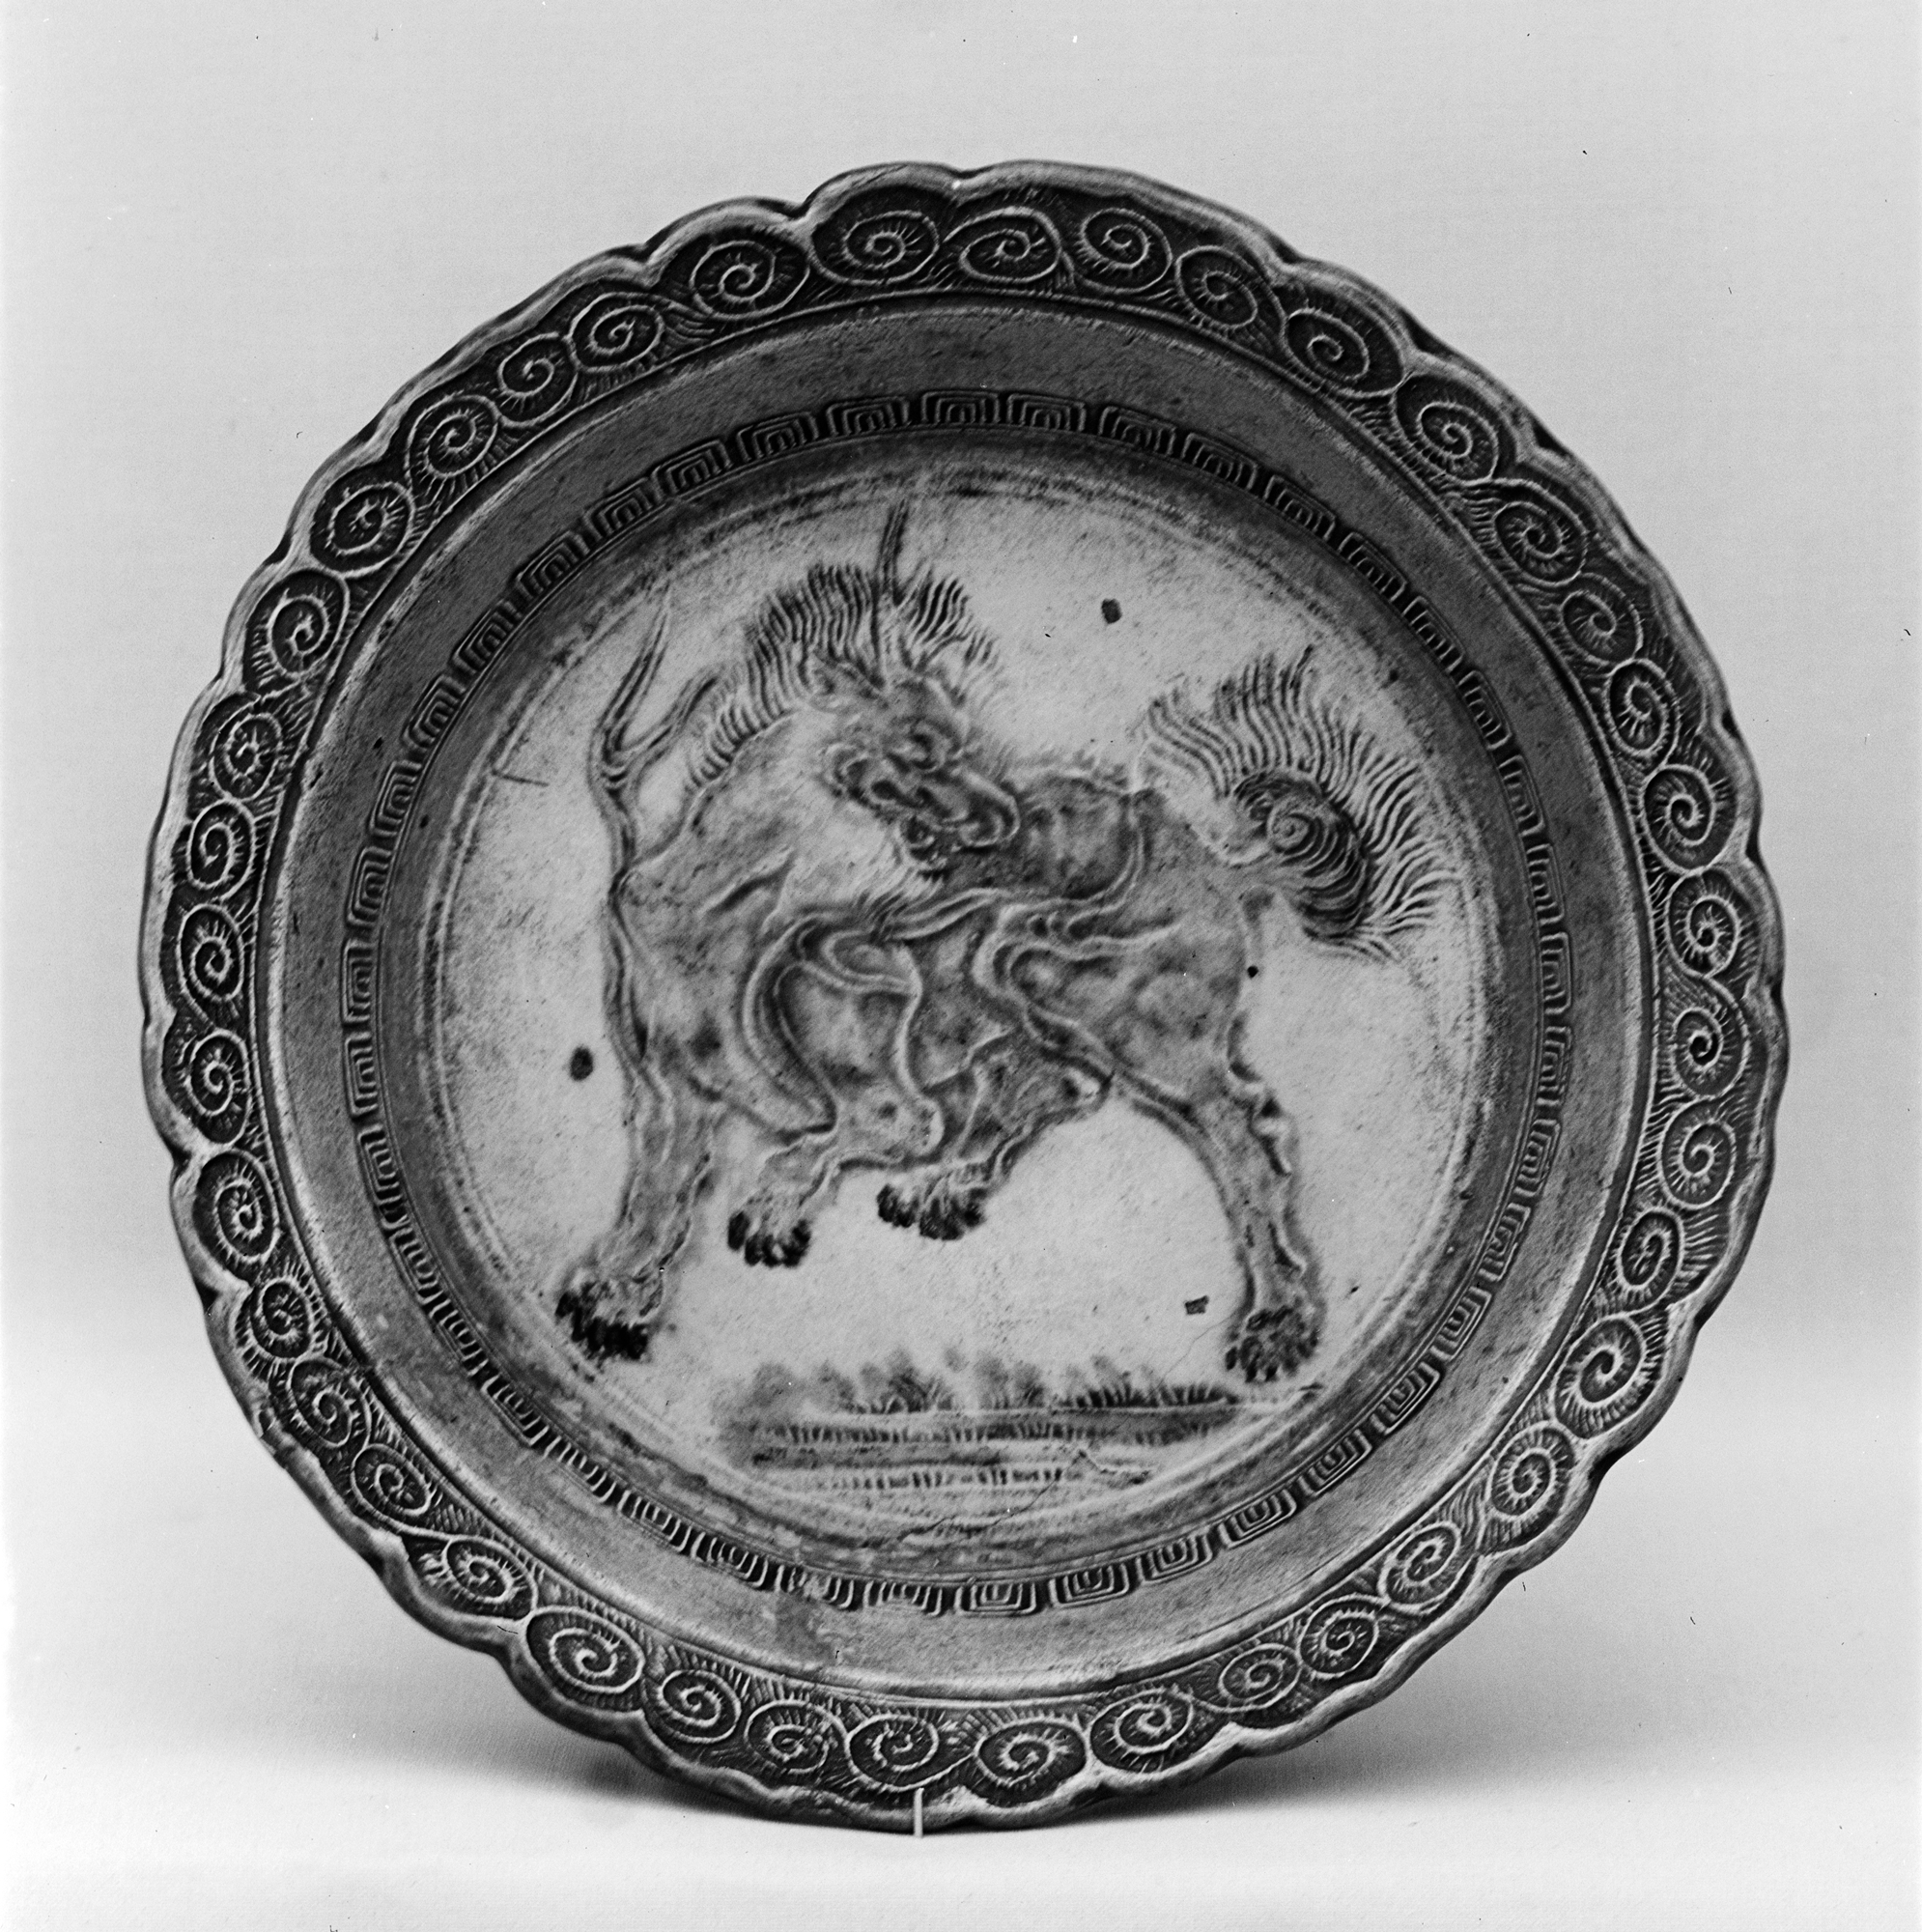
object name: dish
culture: japanese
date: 1701-1800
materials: pottery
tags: animals